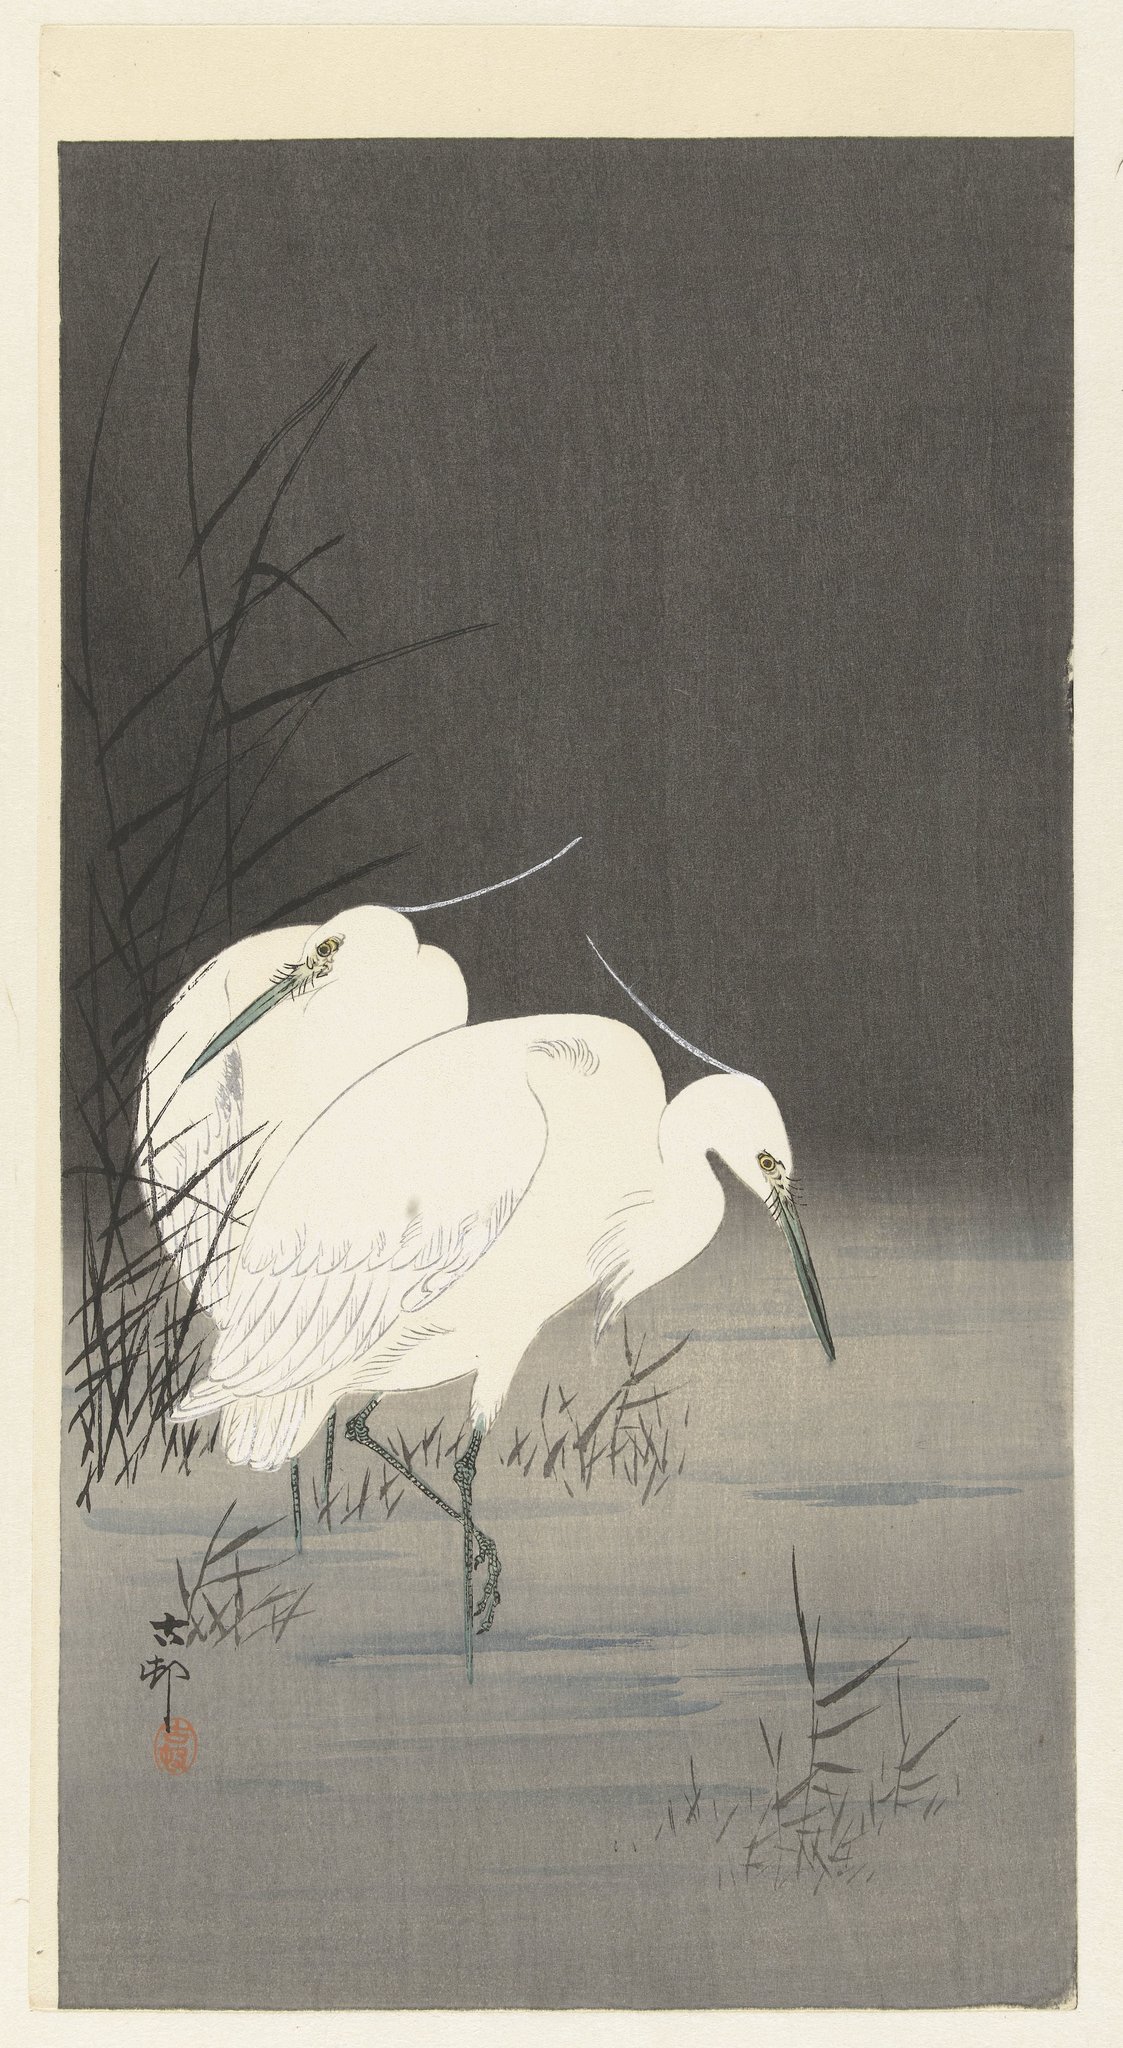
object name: print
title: Twee zilverreigers in het riet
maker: ohara koson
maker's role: print maker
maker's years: 1877-1945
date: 1900-1930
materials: paper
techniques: woodcut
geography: tokyo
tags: shore-birds and wading-birds: heron, water course, plants and herbs: reed, night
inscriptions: collector's mark: Lugt 2228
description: Twee zilverreigers, tussen riet, in laag water, bij nacht.